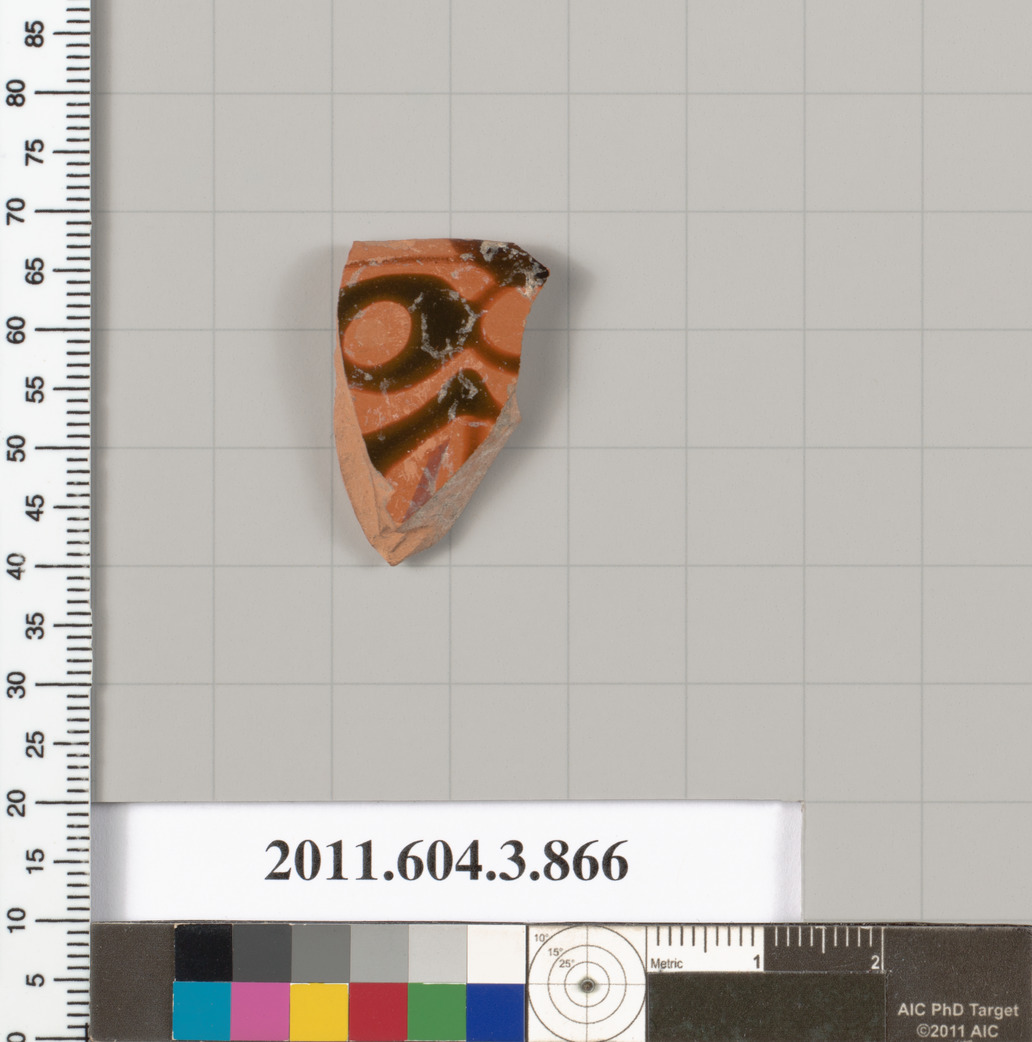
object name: lekythos fragment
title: Terracotta fragment of a lekythos (oil flask)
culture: greek, attic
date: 534-468 BCE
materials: terracotta